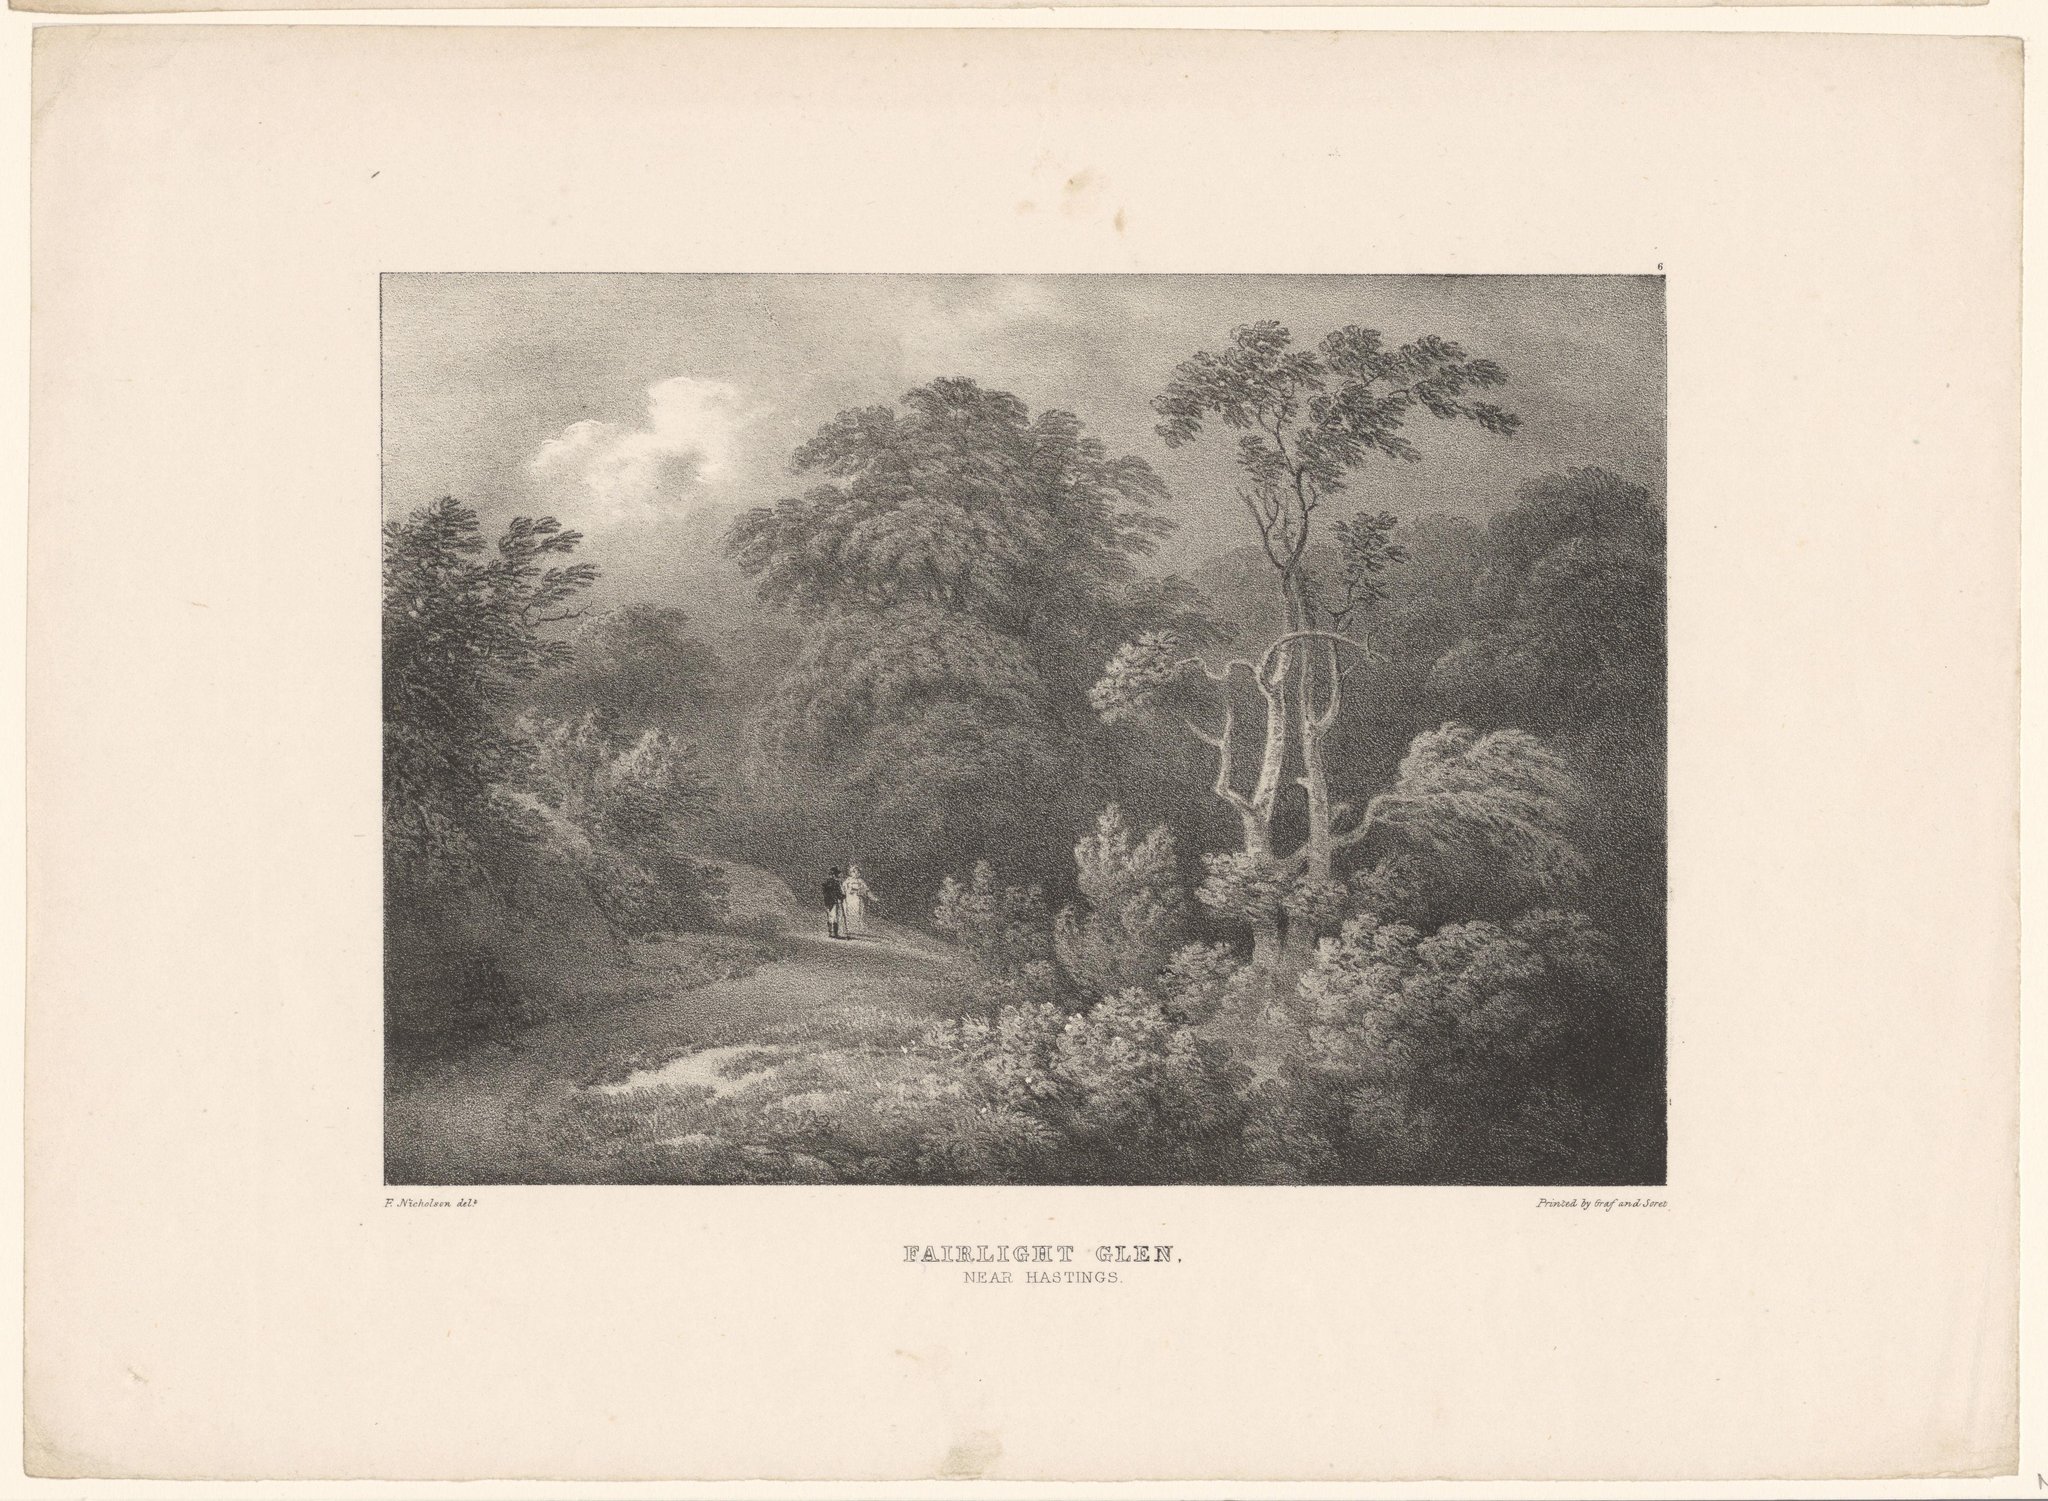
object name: print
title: Fairlight Glen, near Hastings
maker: francis nicholson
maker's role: print maker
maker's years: 1753-1844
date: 1820-1844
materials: paper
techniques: lithograph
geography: london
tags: landscapes in the temperate zone (+ landscape with figures, staffage)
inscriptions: collector's mark: Lugt 2228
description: Prent maakt mogelijk deel uit van een serie met landschappen en stadsgezichten. Over deze serie is verder niets bekend. Het betreft voornamelijk gezichten in Engeland.